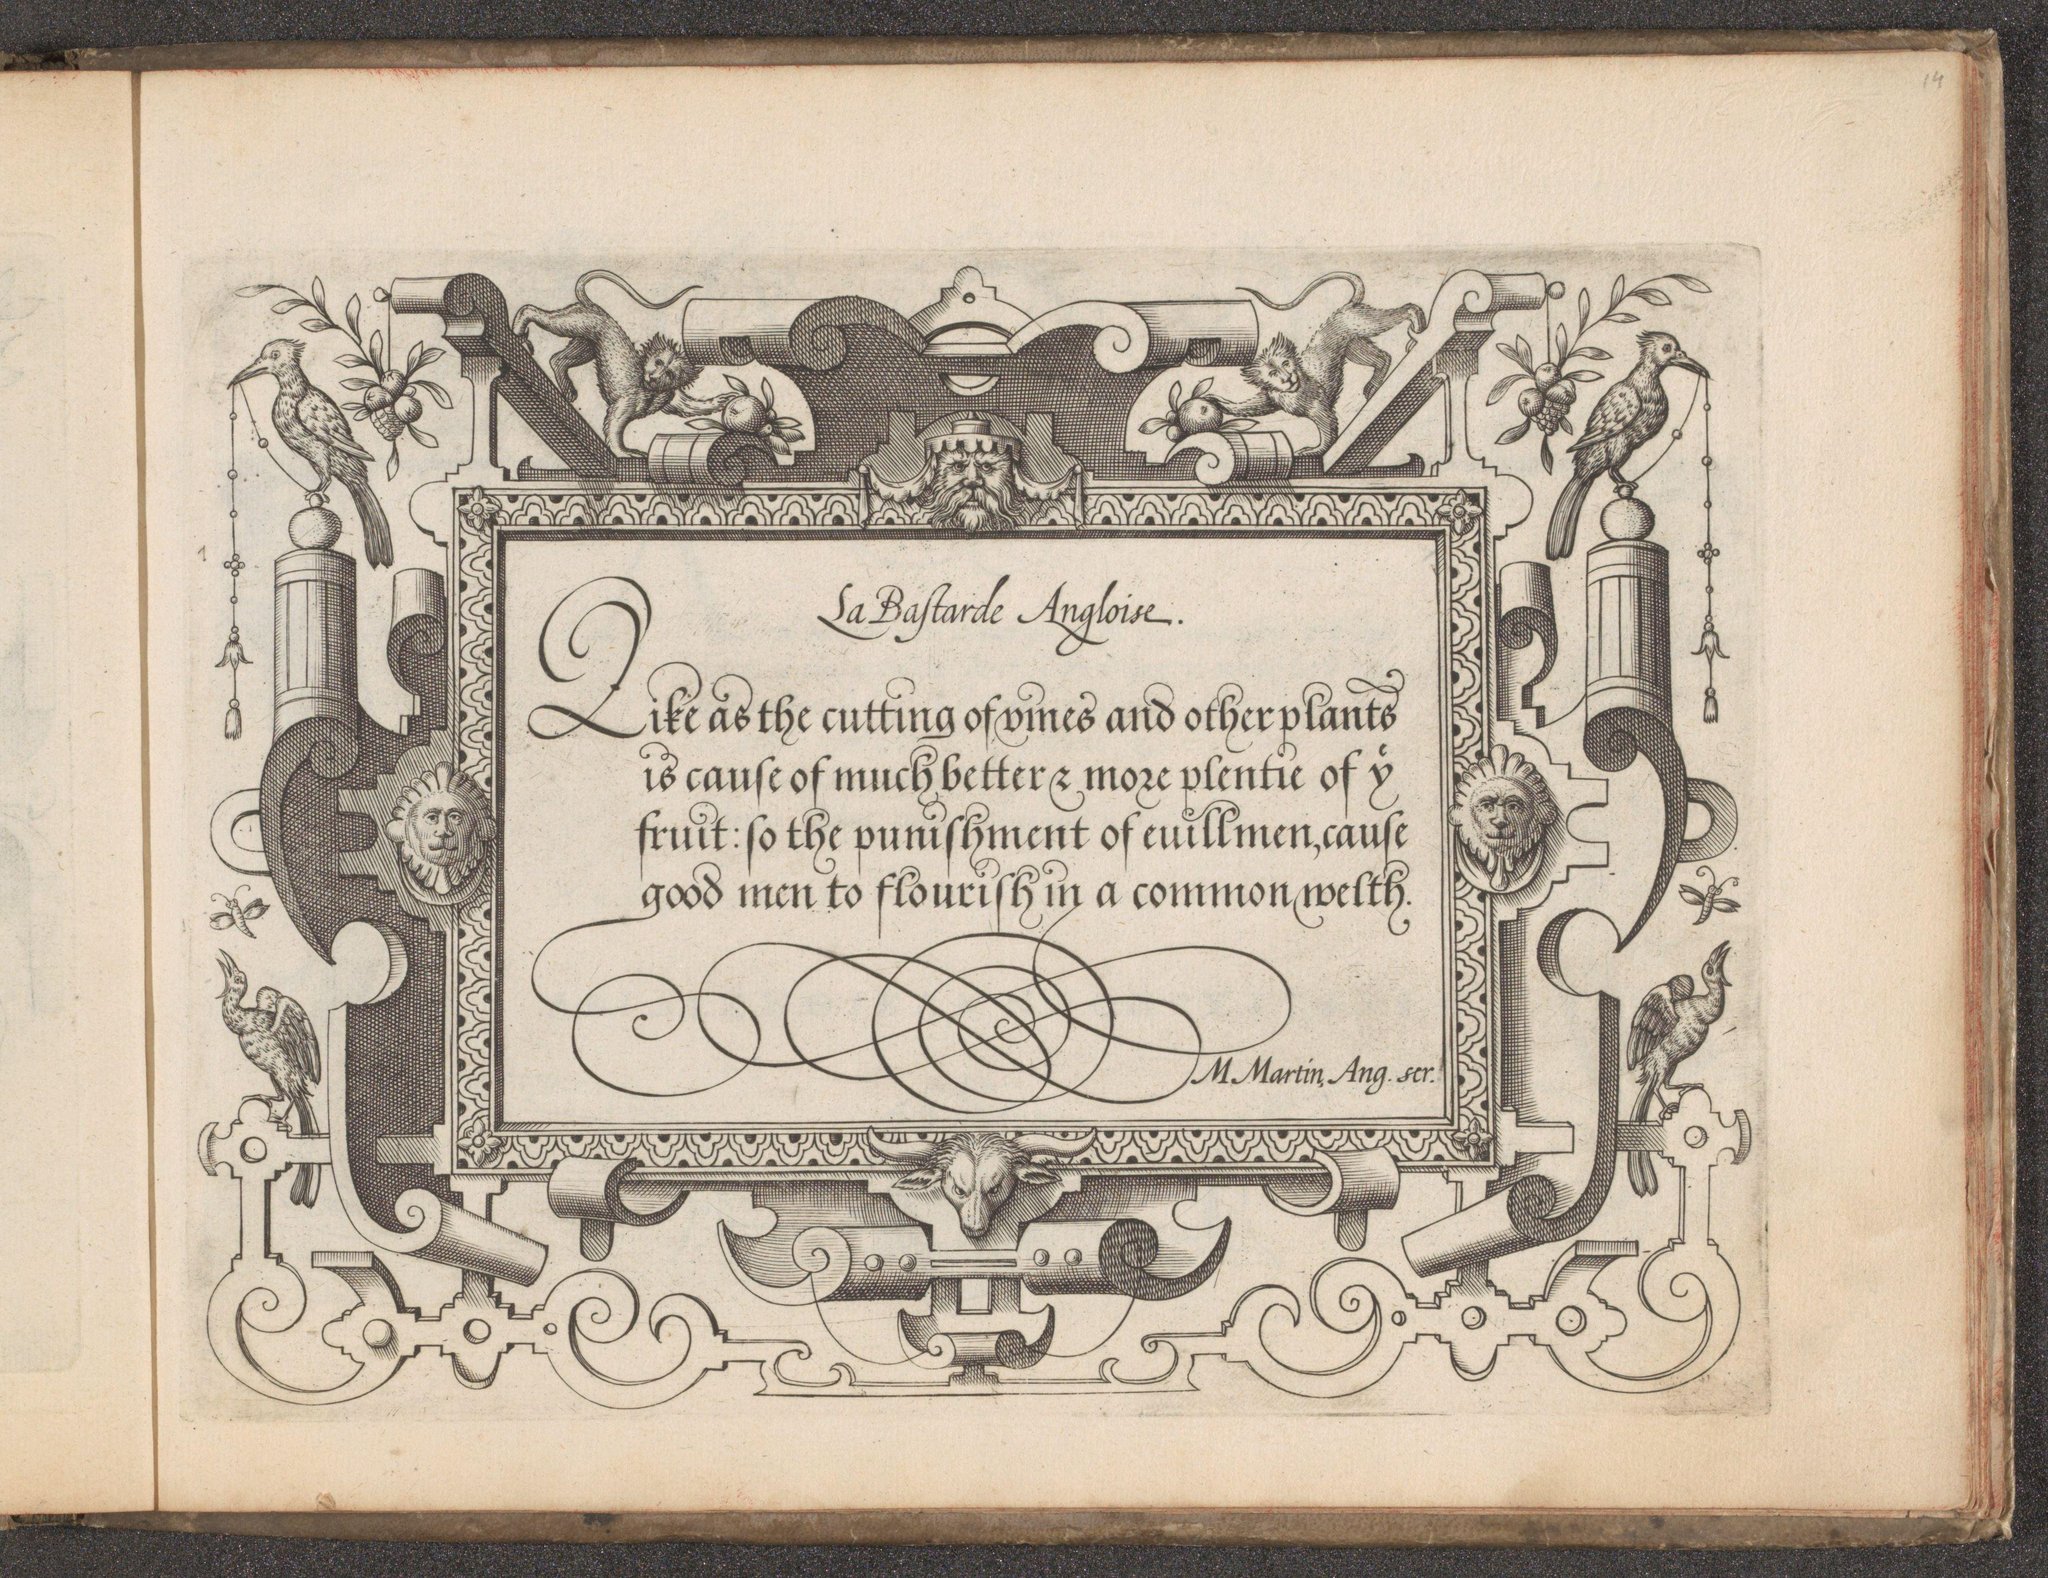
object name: album leaf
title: Schrijfvoorbeeld: Like as the cutting of vines and other plants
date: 1614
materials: paper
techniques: engraving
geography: amsterdam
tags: scrollwork, strapwork ~ ornament, birds, ornament ~ cartouche, mask, mascaron ~ ornament, calligraphy, beasts of prey, predatory animals: lion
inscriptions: signature and date: ‘Op titelblad: Judoco Hondio celatore. Amstelodami apud Joannem Janssonium. 1614’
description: Schrijfvoorbeeld in een gotische hand met een titel in het Frans en vier regels tekst in het Engels. Daarbij wat krulwerk. Het voorbeeld is gevat in een rolwerkcartouche met bovenaan twee leeuwenwelpen. Verder vier mascarons en vier vogels. De prent maakt deel uit van een album.